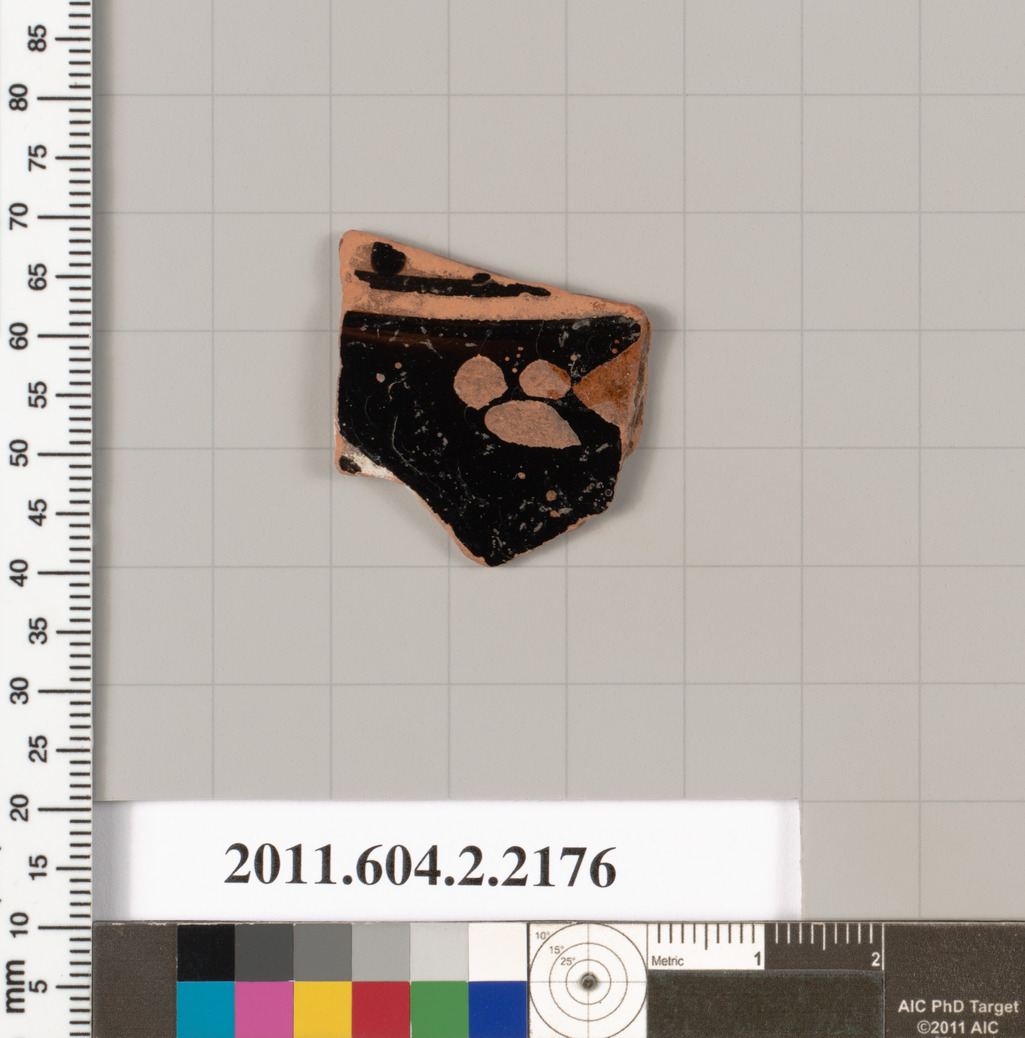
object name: pot fragment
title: Terracotta fragment of a pot; unglazed on the inside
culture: greek, attic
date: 450-426 BCE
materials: terracotta